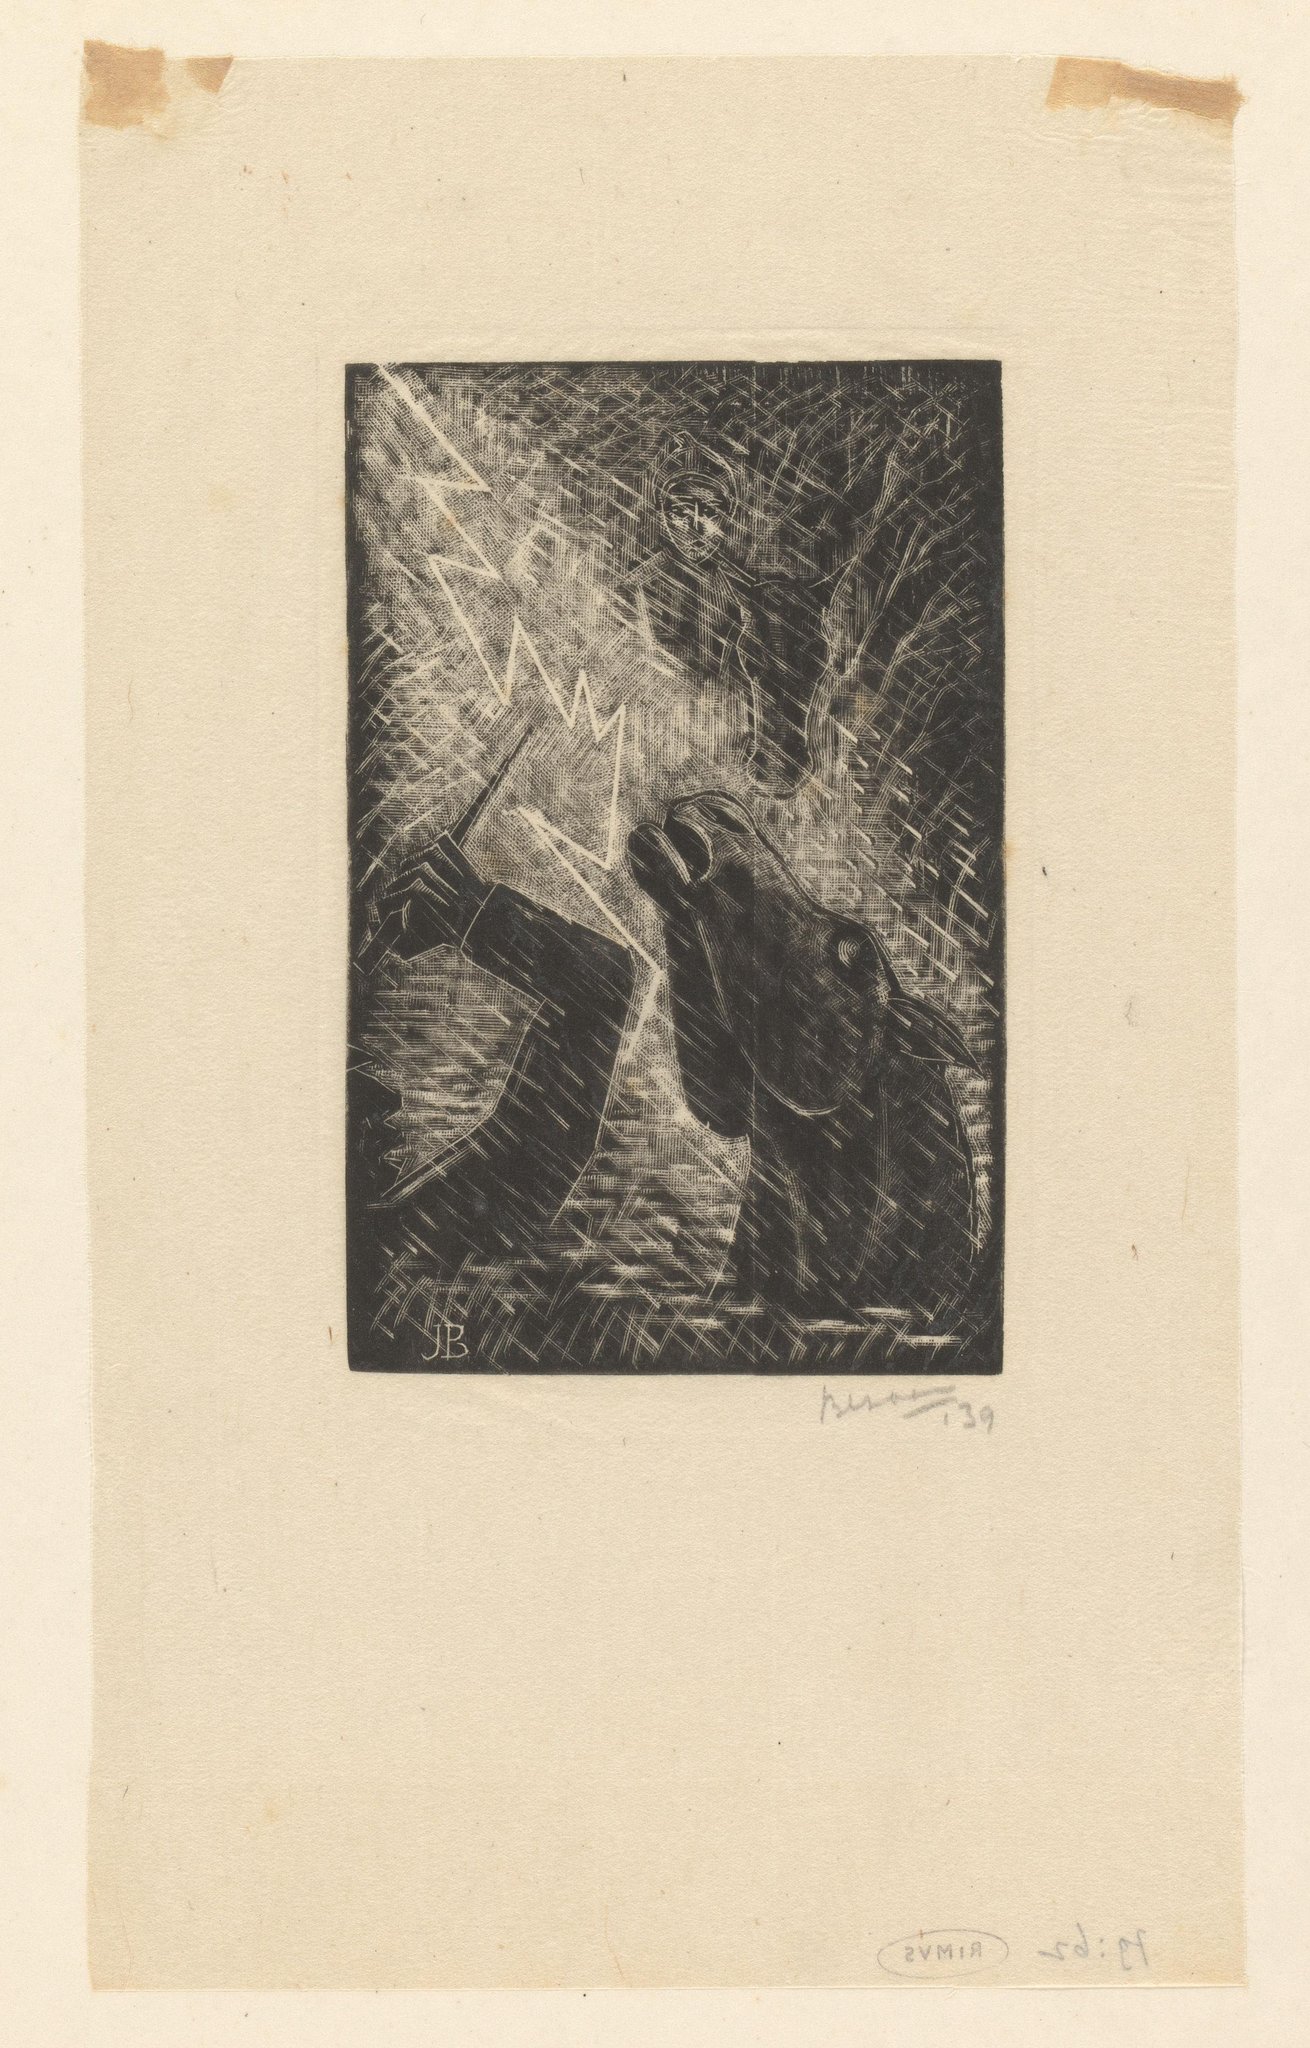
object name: print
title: Ruiter, paardenhoofd, geheven mannenarm en bliksem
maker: jo bezaan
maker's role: draughtsman, print maker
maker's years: 1894-1952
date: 1939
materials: paper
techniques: engraving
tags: riding a horse, ass, or mule; rider, horseman, lightning, flash of lightning, thunderbolt, horse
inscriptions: collector's mark: Lugt 2228